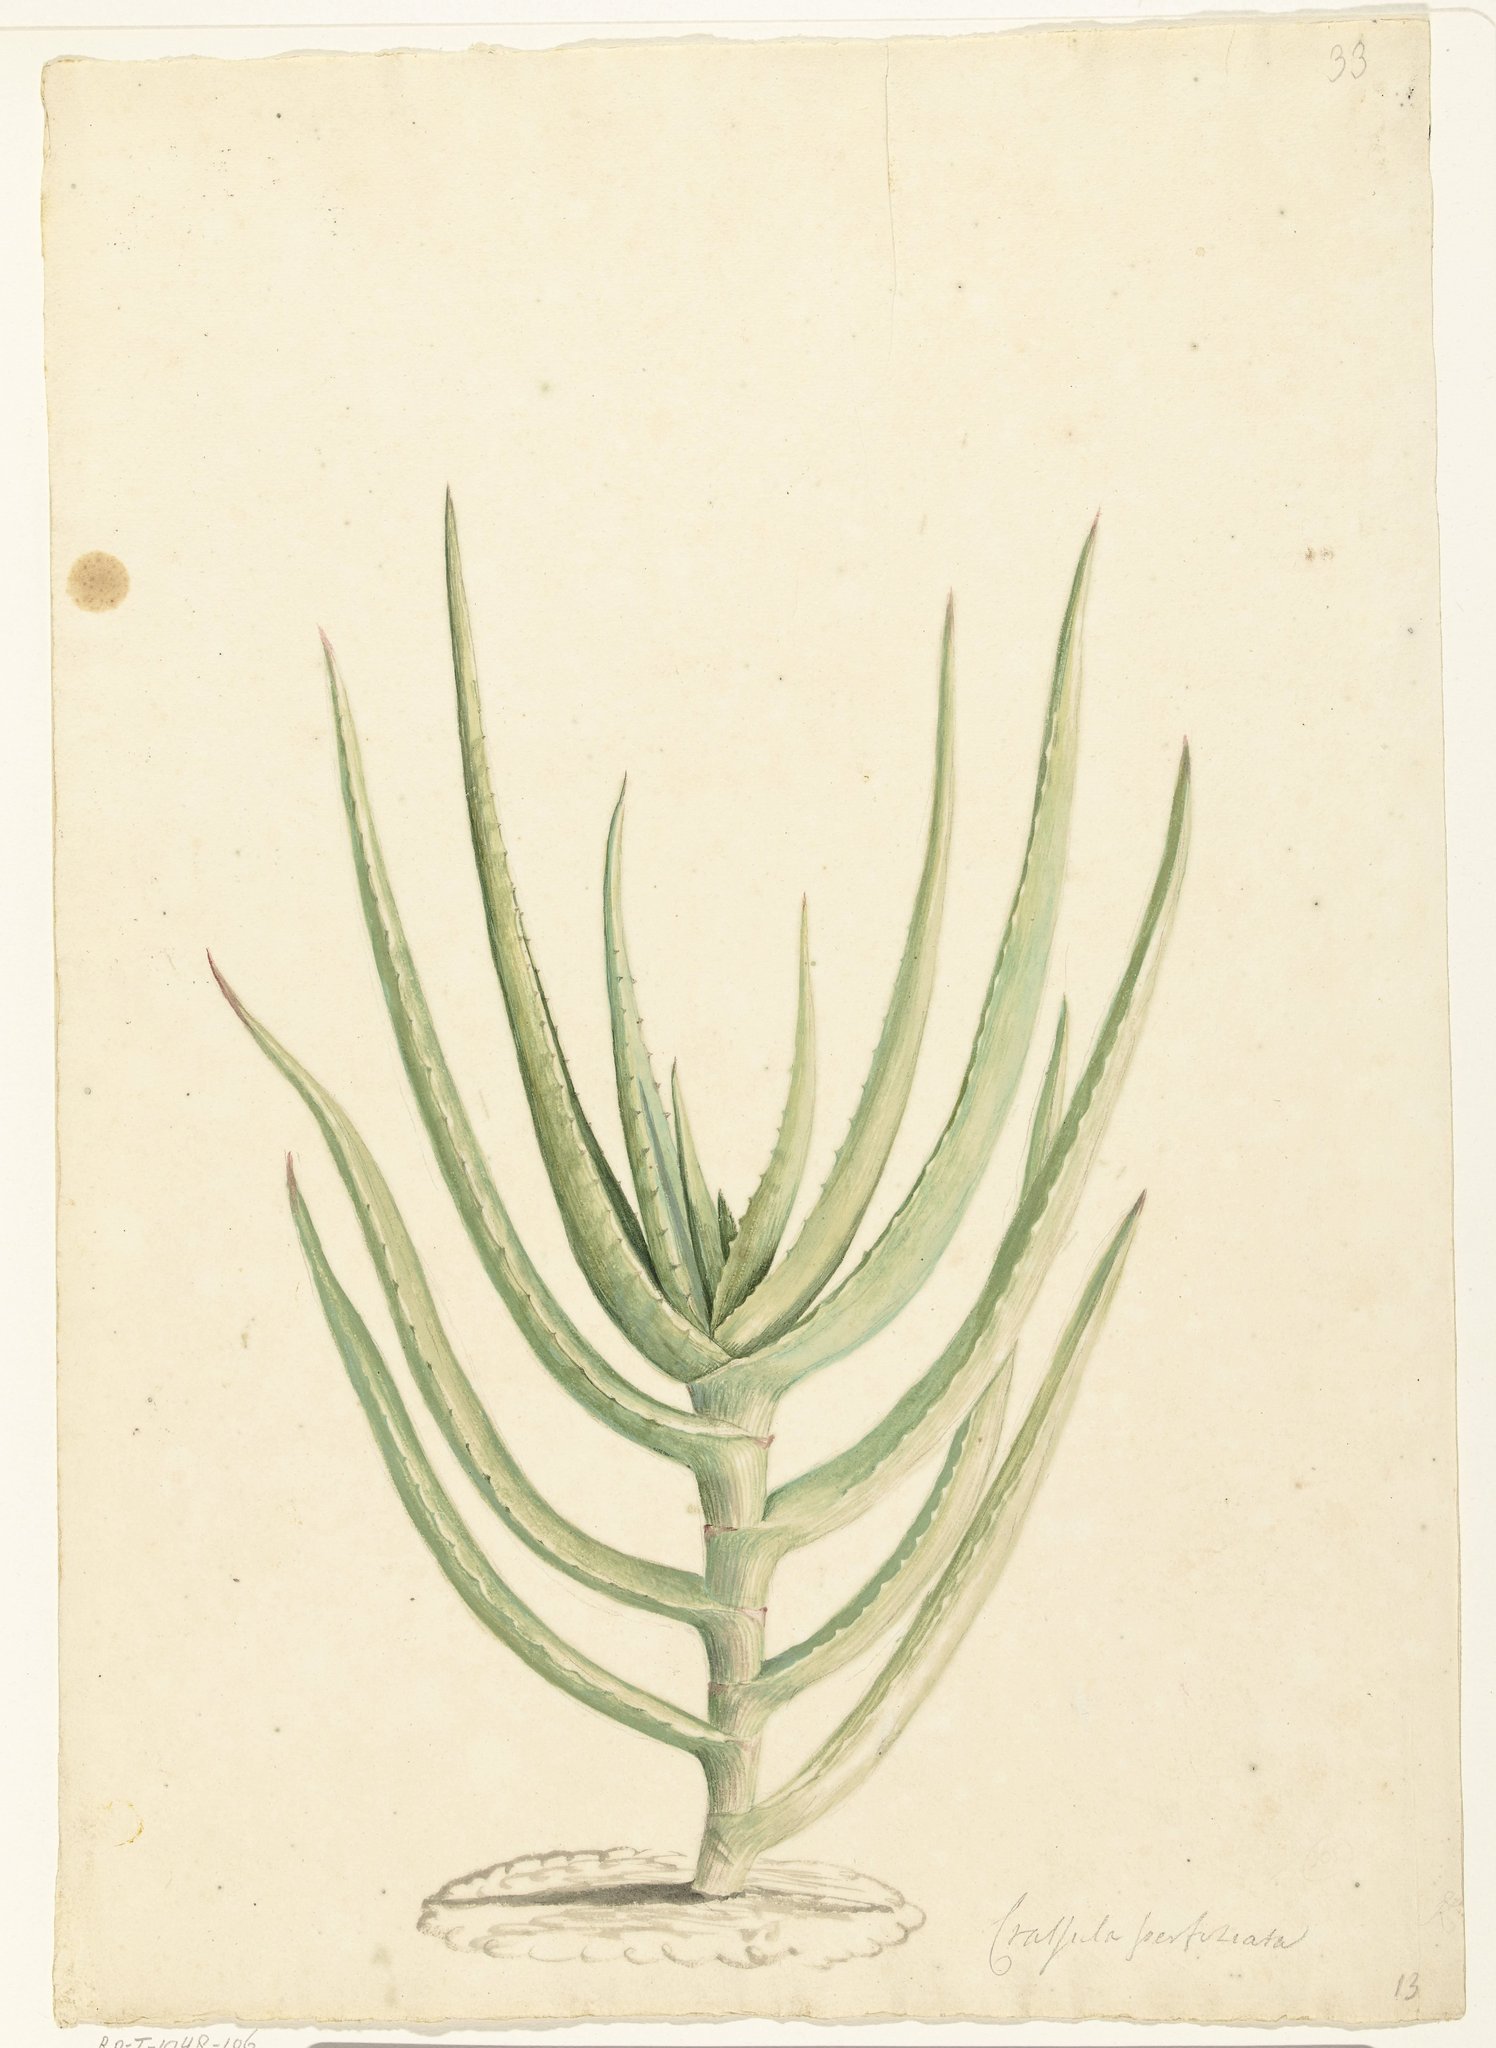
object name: watercolor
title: Crassula perfoliata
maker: laurens vincentsz. van der vinne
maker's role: draughtsman, print maker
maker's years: 1658-1729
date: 1668-1729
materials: paper, watercolor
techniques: brush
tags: plants and herbs: crassula